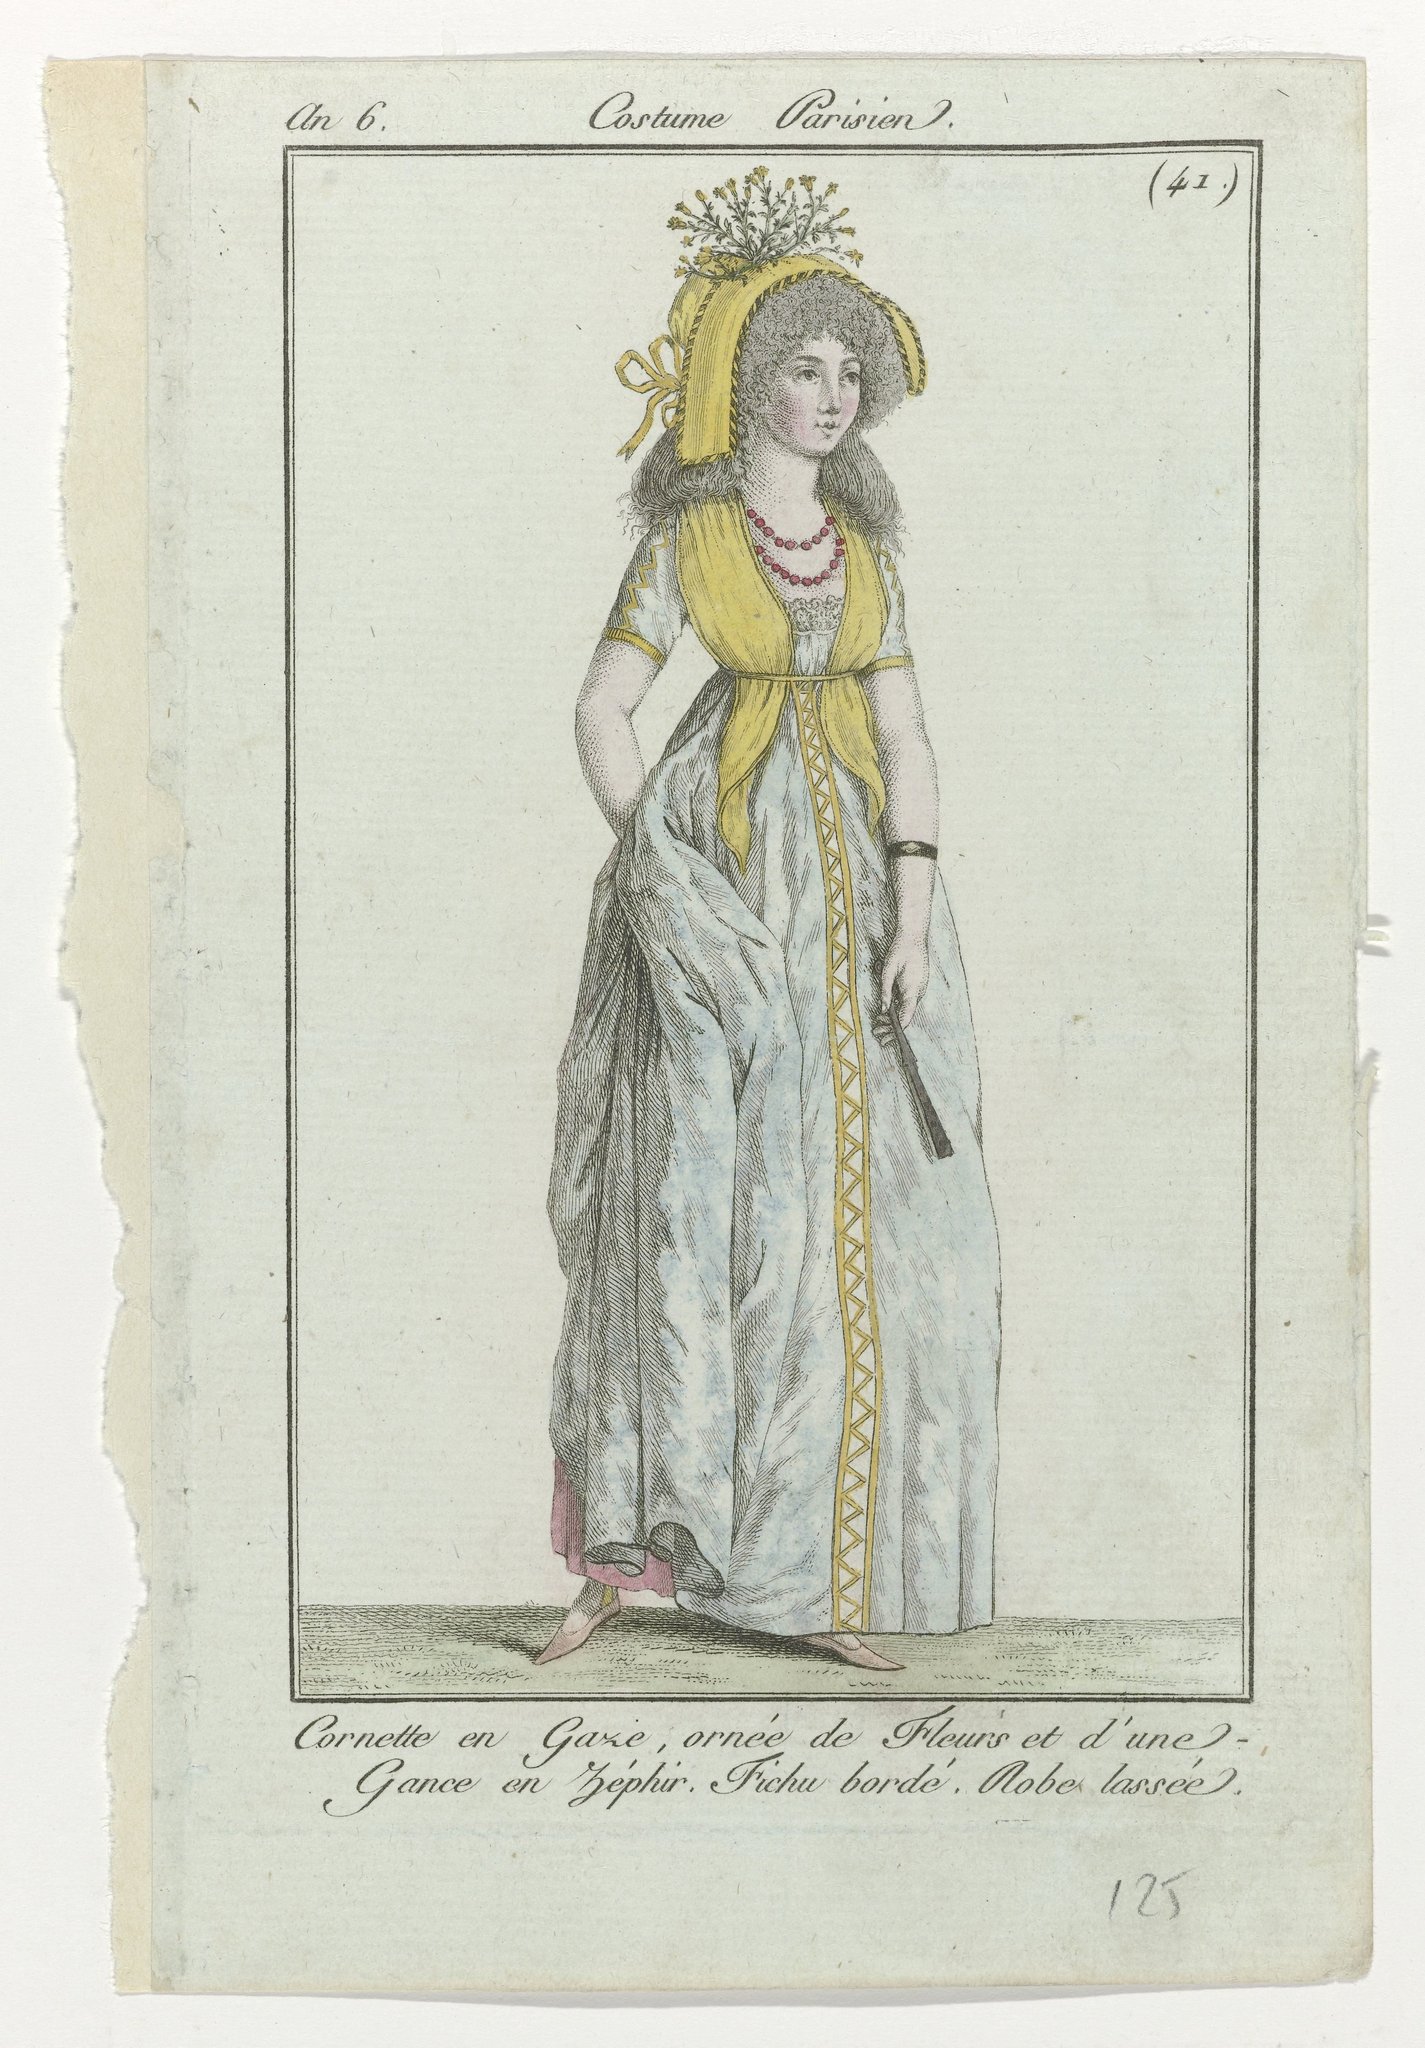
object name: fashion print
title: Journal des Dames et des Modes, Costume Parisien, 2 juin 1798, An 6, (41) : Cornette en Gaz (...)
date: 1798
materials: paper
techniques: engraving, hand coloring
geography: paris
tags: head-gear (cornette) (+ women's clothes), fashion plates, shoes, sandals (+ women's clothes), dress, gown (+ women's clothes), fan (+ women's clothes), piece of clothing covering the breast or décolleté (fichu) (+ women's clothes), bracelet, wristlet (+ women's clothes), necklace (+ women's clothes)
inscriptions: caption: ‘Cornette en Gaze, ornée de Fleurs et d'une Gance en Zéphir. Fichu bordé. Robe lassée.’, title: ‘Costume Parisien.’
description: 'Cornette' van tule, versierd met bloemen en een bies van 'zéphir'. Fichu, waarvan de slippen onder het ceintuur(?) zijn doorgehaald. Japon met korte mouwen en middenvoor een rijgsluiting. Verdere accessoires: om de hals twee kettingen, armband om de pols, waaier, kousen, platte schoenen met puntige neuzen. De prent maakt deel uit van het modetijdschrift Journal des Dames et des Modes, uitgegeven door Sellèque, Parijs, 1797-1839.